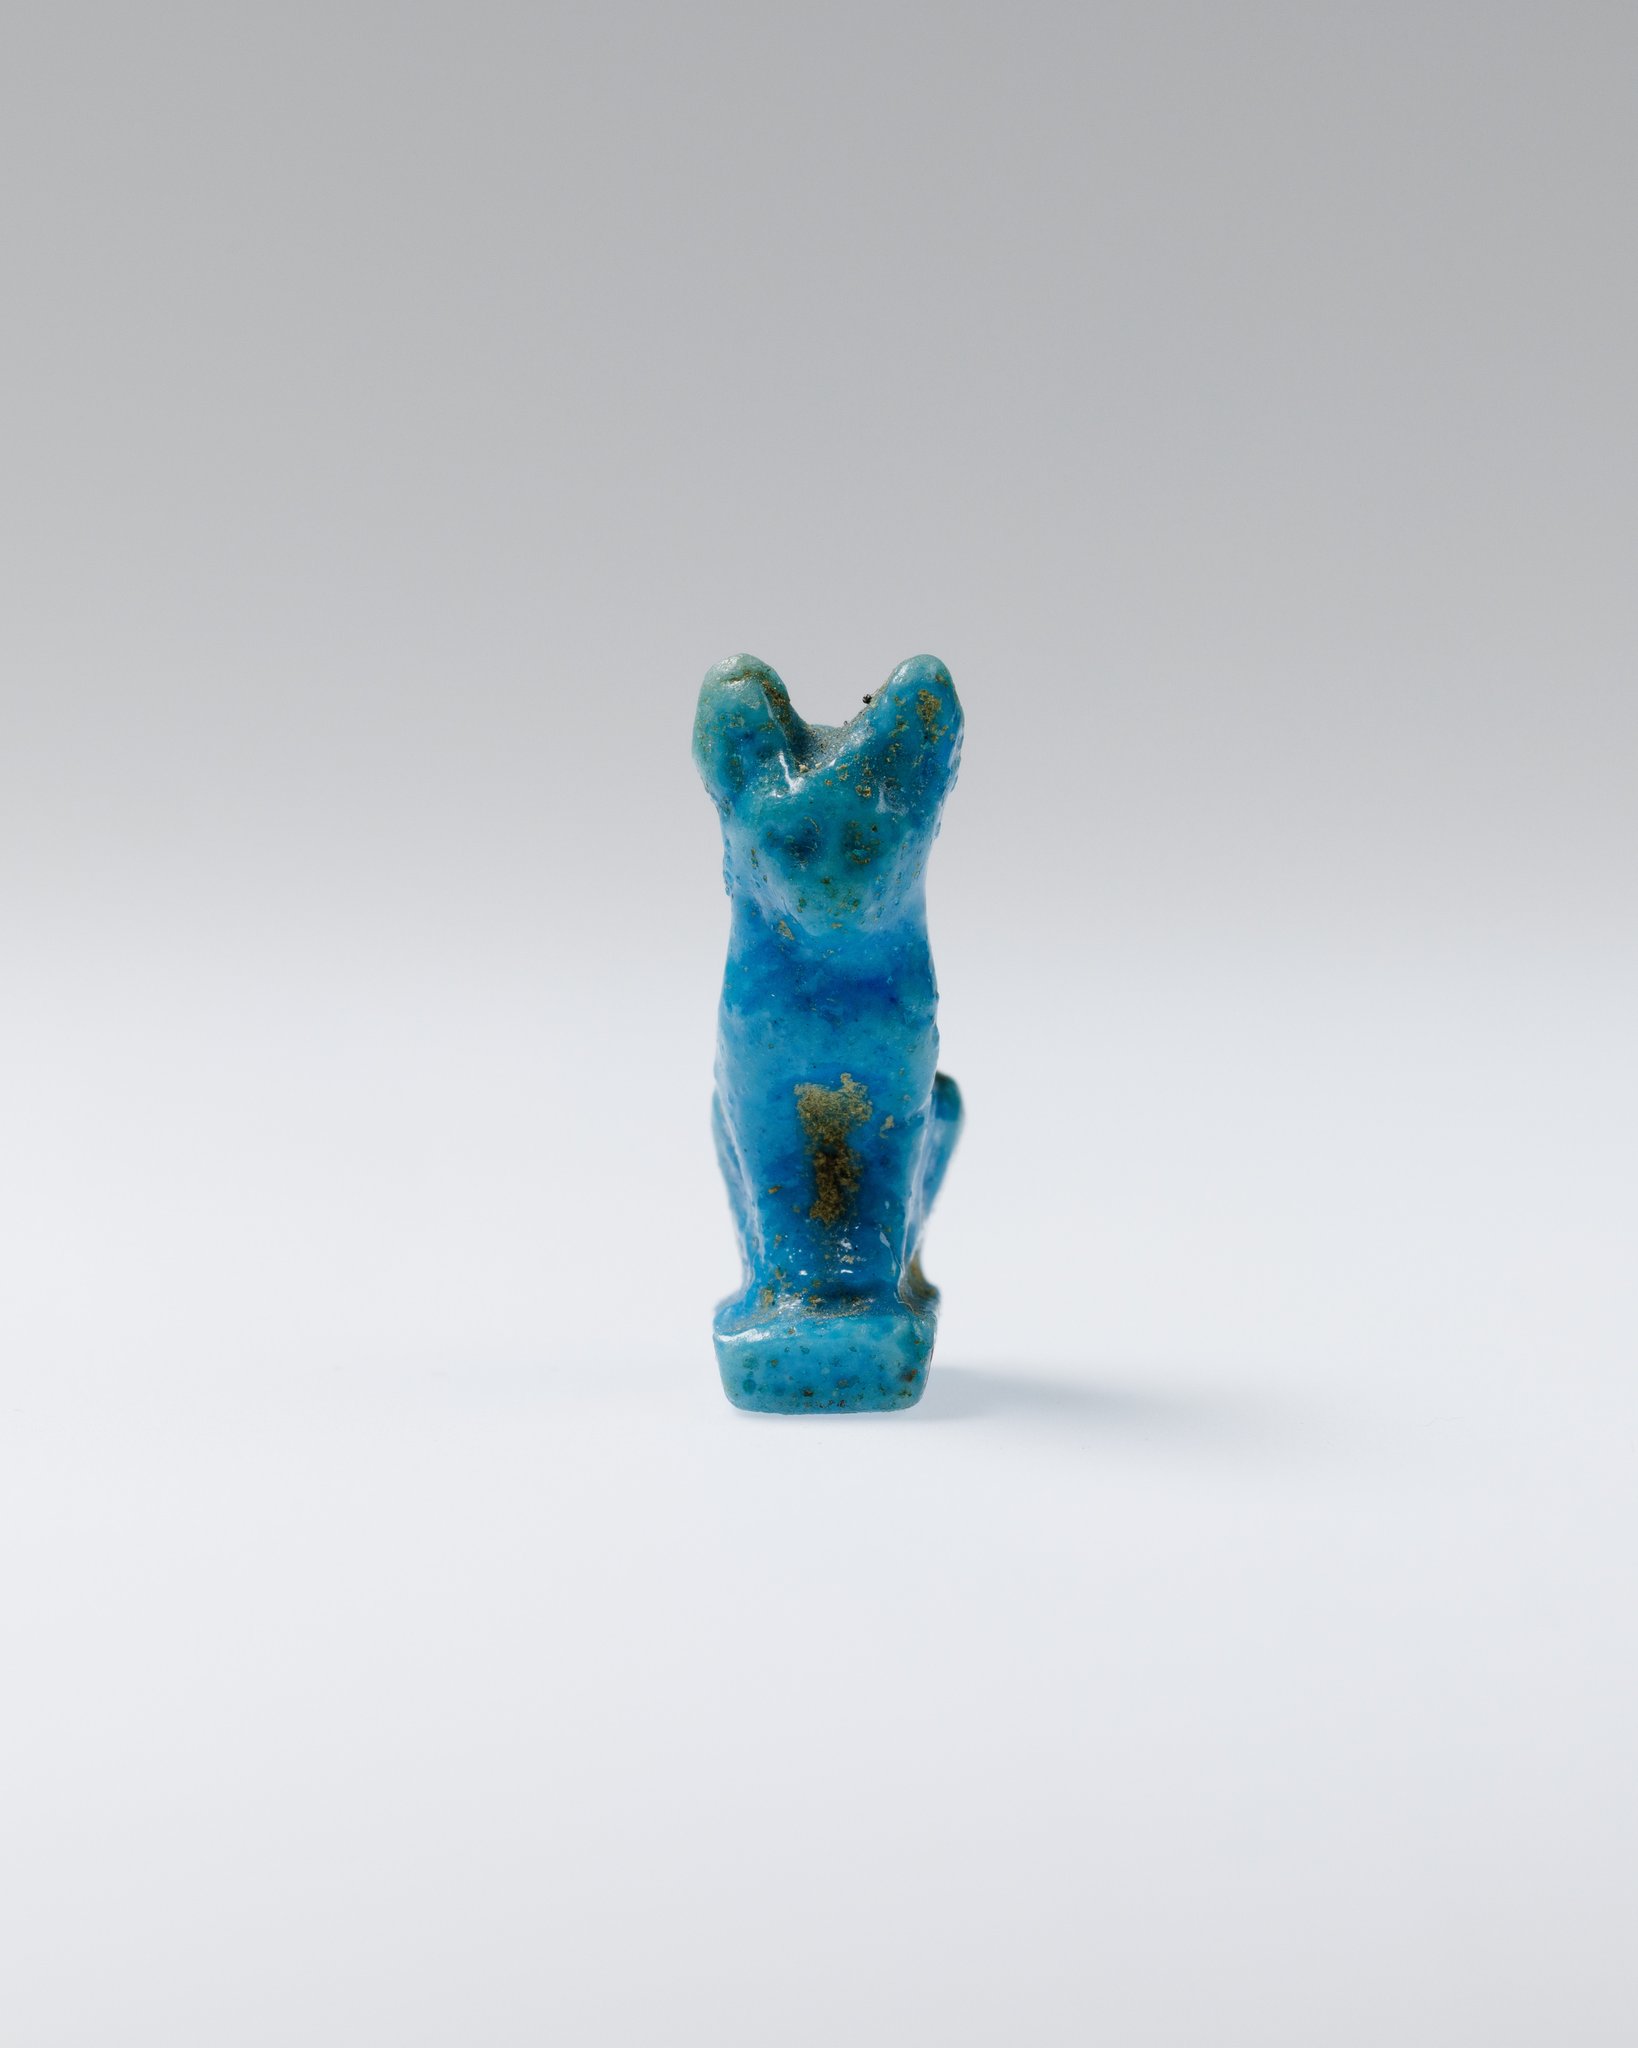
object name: amulet, cat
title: Cat amulet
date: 664-630 BCE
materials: faience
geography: egypt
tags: cats